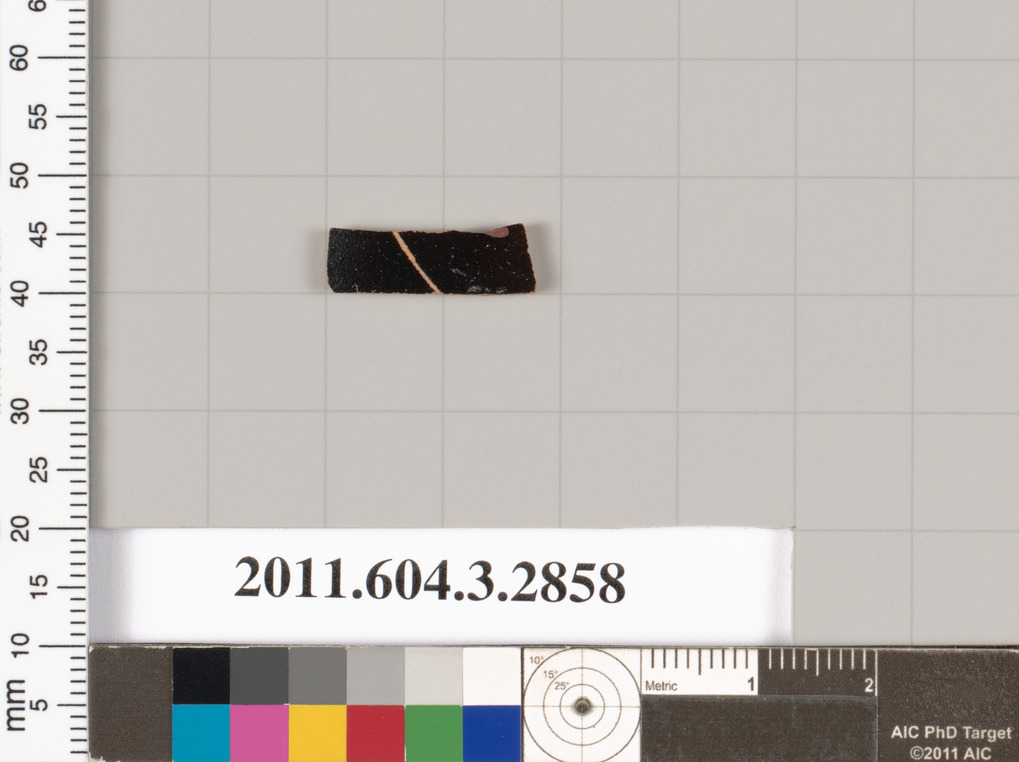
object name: undetermined closed shape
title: Terracotta fragment of a closed shape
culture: greek, attic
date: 534-468 BCE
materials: terracotta